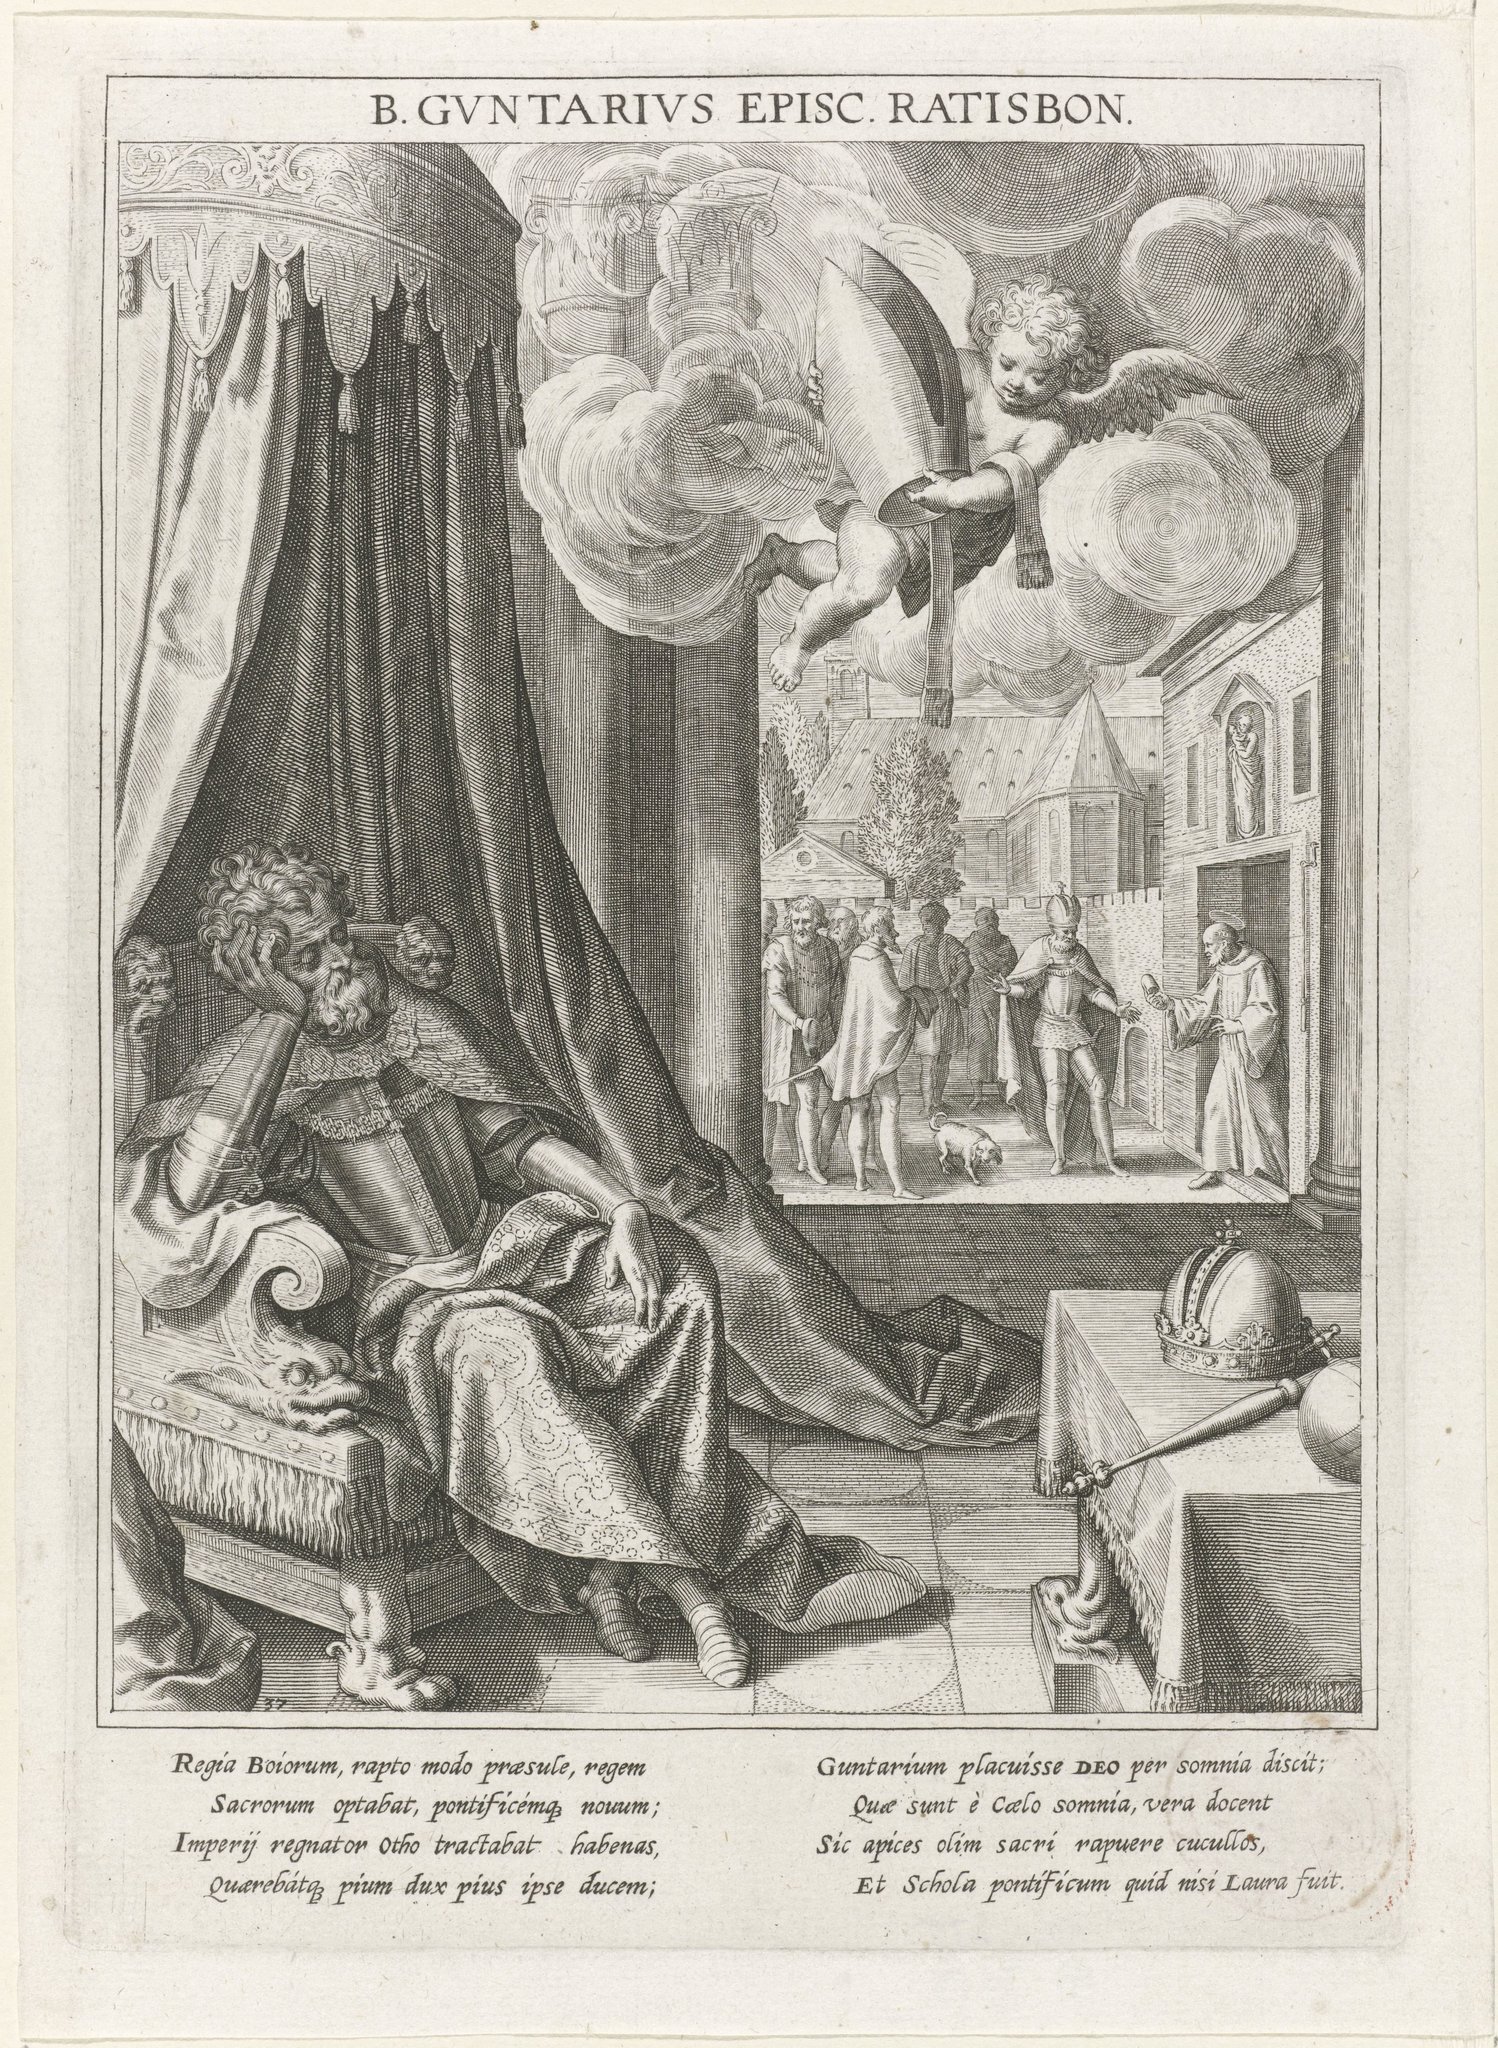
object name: print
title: B. Gvntarius episc. Ratisbon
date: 1615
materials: paper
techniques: engraving, etching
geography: munich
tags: male saints (with name), angels crowning and/or bringing palm-branches, insignia of bishop, e.g. mitre, crozier, prophetic dream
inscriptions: collector's mark: Lugt 240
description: Op de voorgrond keizer Otto de Grote slapend in een stoel. In de lucht vliegt een engeltje met een mijter. Keizer Otto krijgt in zijn droom een visioen dat hij de eerste geestelijke die hij bij ontwaken tegenkomt moet uitroepen als bisschop van Regensburg. Op de achtergrond ontmoet keizer Otto na zijn ontwaken de Heilige Gunther, de poortwachter van het klooster St. Emmeram. De H. Gunther biedt de keizer een schoen aan in ruil voor de bisschopsambt van Regensburg. De prent heeft een Latijns onderschrift en is de 37ste prent van een 60-delige serie met als onderwerp de heiligen van Beieren.